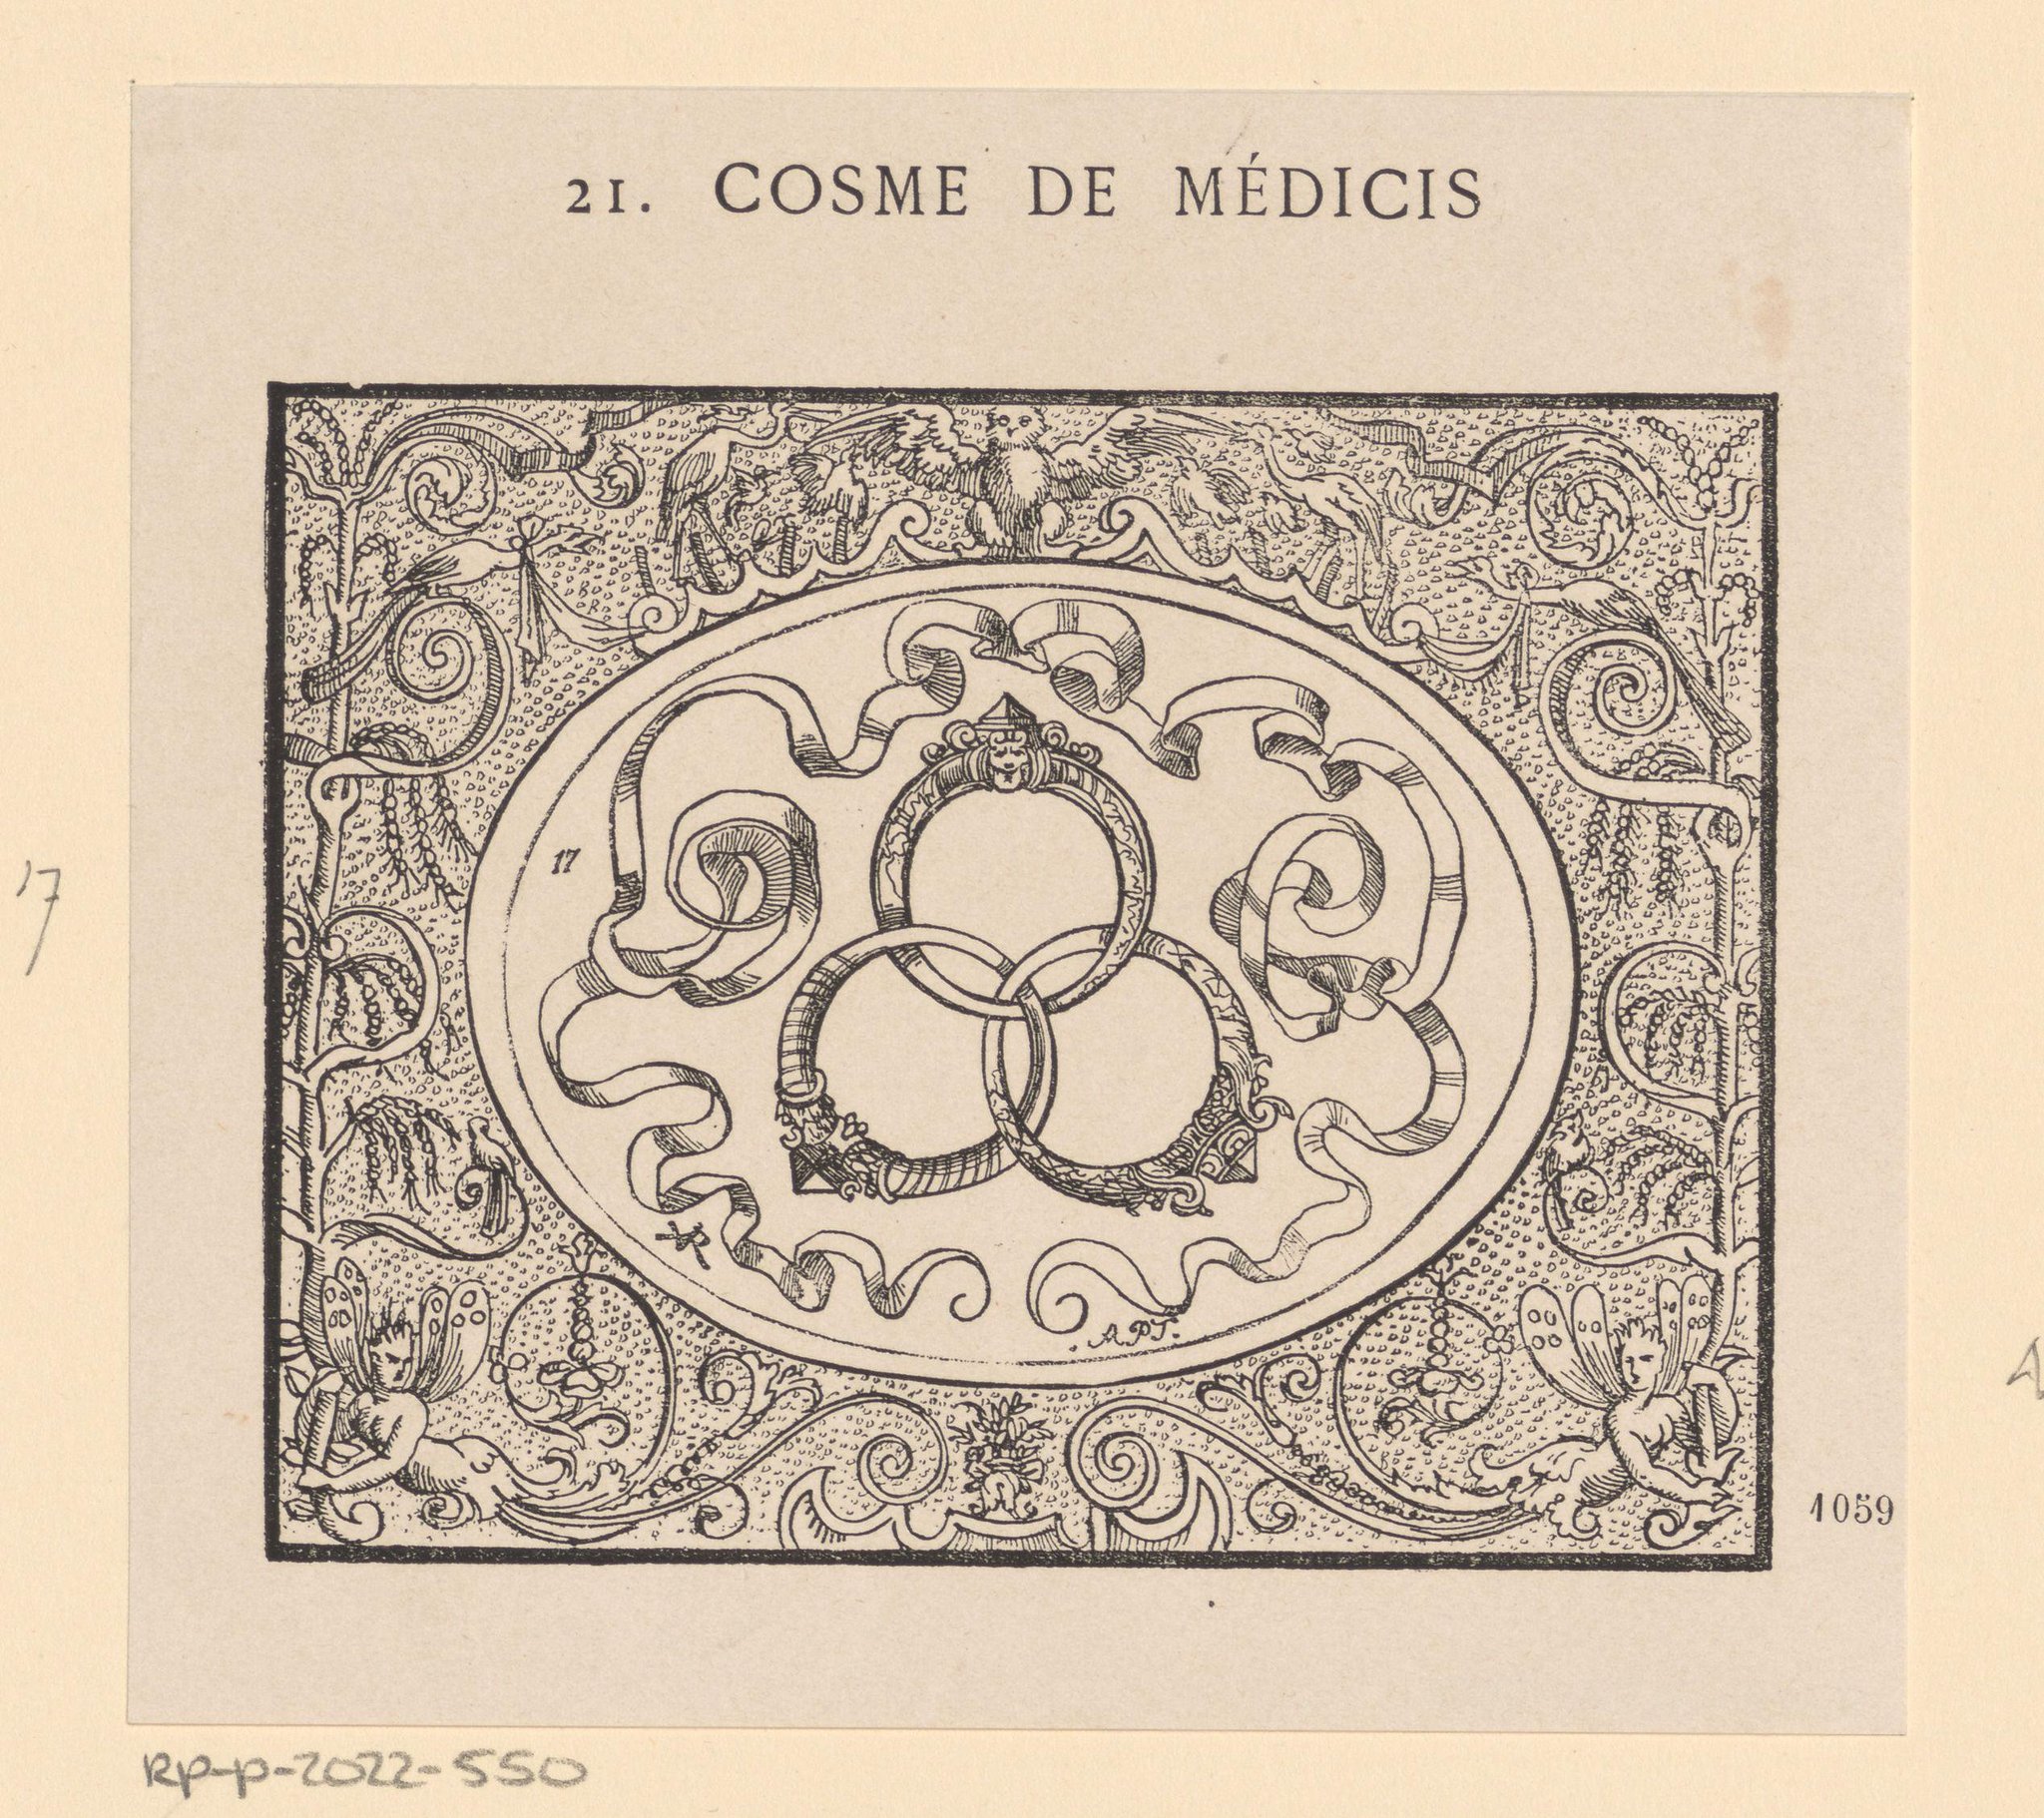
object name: book illustration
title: Wapen van Cosimo de' Medici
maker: Anonymous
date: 1864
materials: paper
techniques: line block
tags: coat of arms (symbol of sovereignty)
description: Afdruk waarschijnlijk uit: Reiber, Émile. L'Art pour tous. Parijs: A. Morel etc., 1864, dl. 4, nr. 116, p. 464.